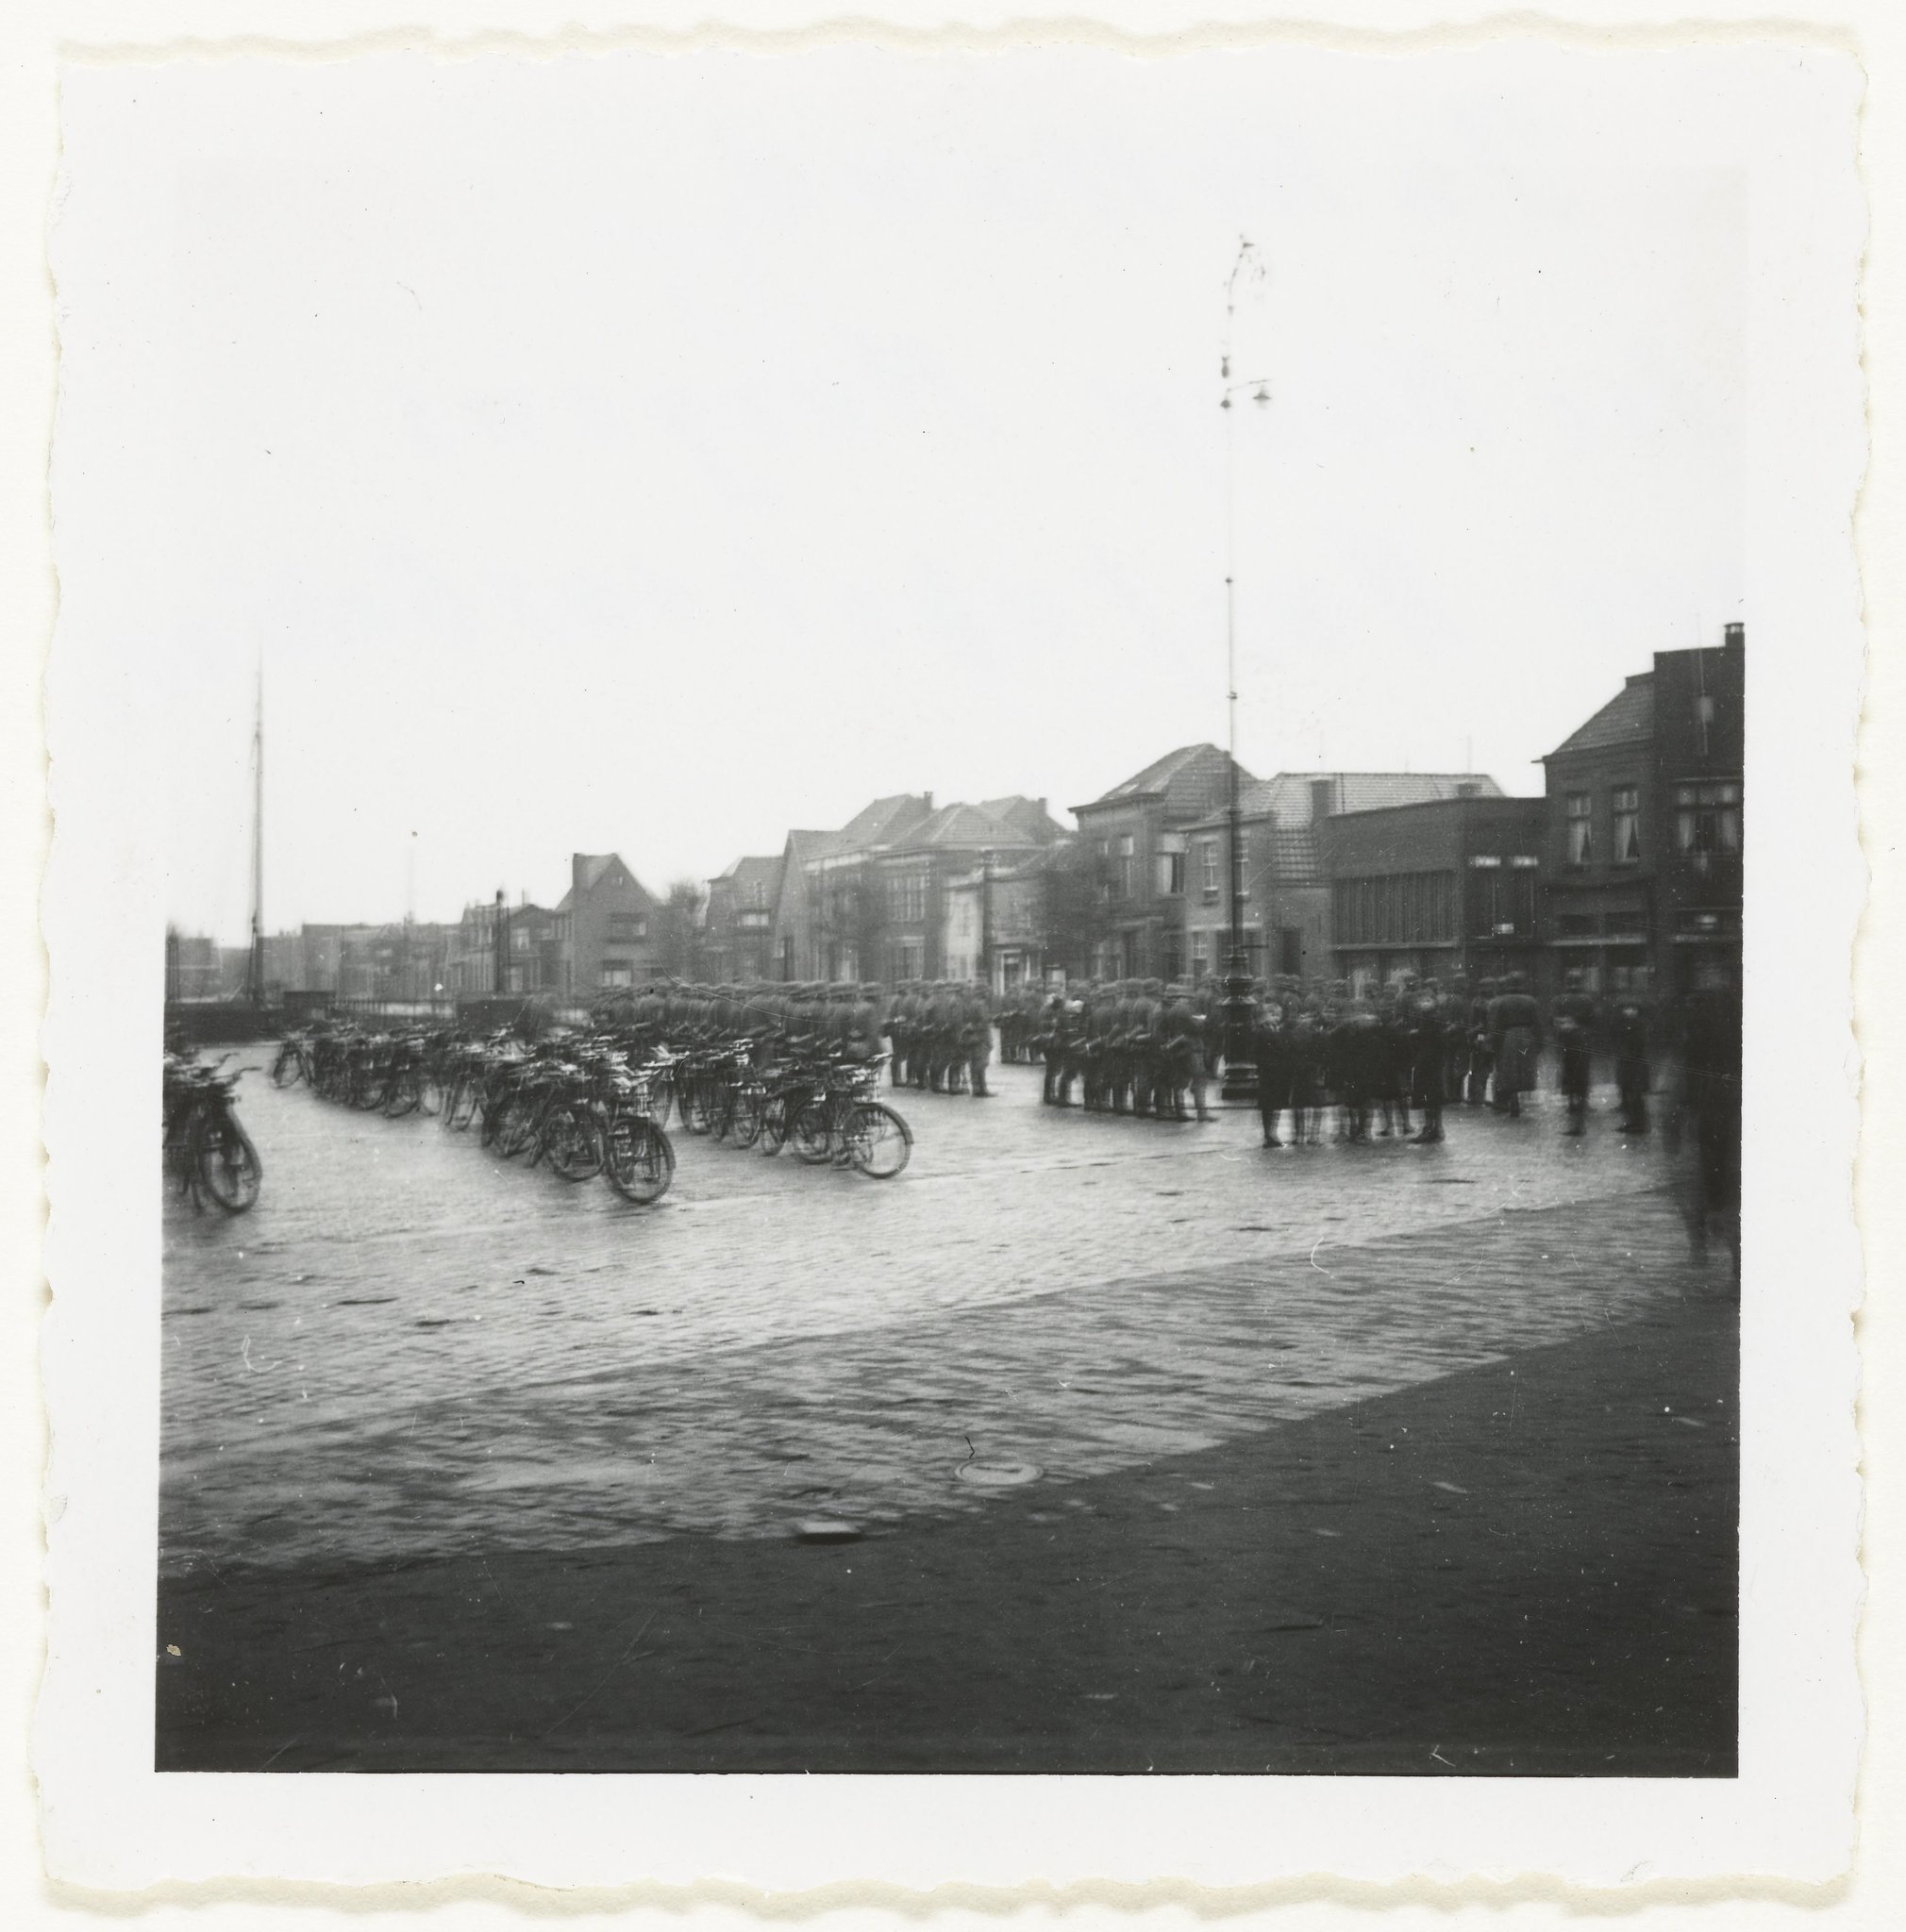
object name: photograph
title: Wehrmacht soldaten gereed voor vertrek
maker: Anonymous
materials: photographic support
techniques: gelatin silver print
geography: raamsdonksveer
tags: army 'en route', assembling of military forces; mobilization, troop concentration, etc., occupation ~ war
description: Kompagnie Wehrmacht soldaten staat in rijen met fietsen klaar om op oefening te gaan. Achterop staat: In Holland. Die Komp. Morgens vor Ausfahrt ins Gelände.